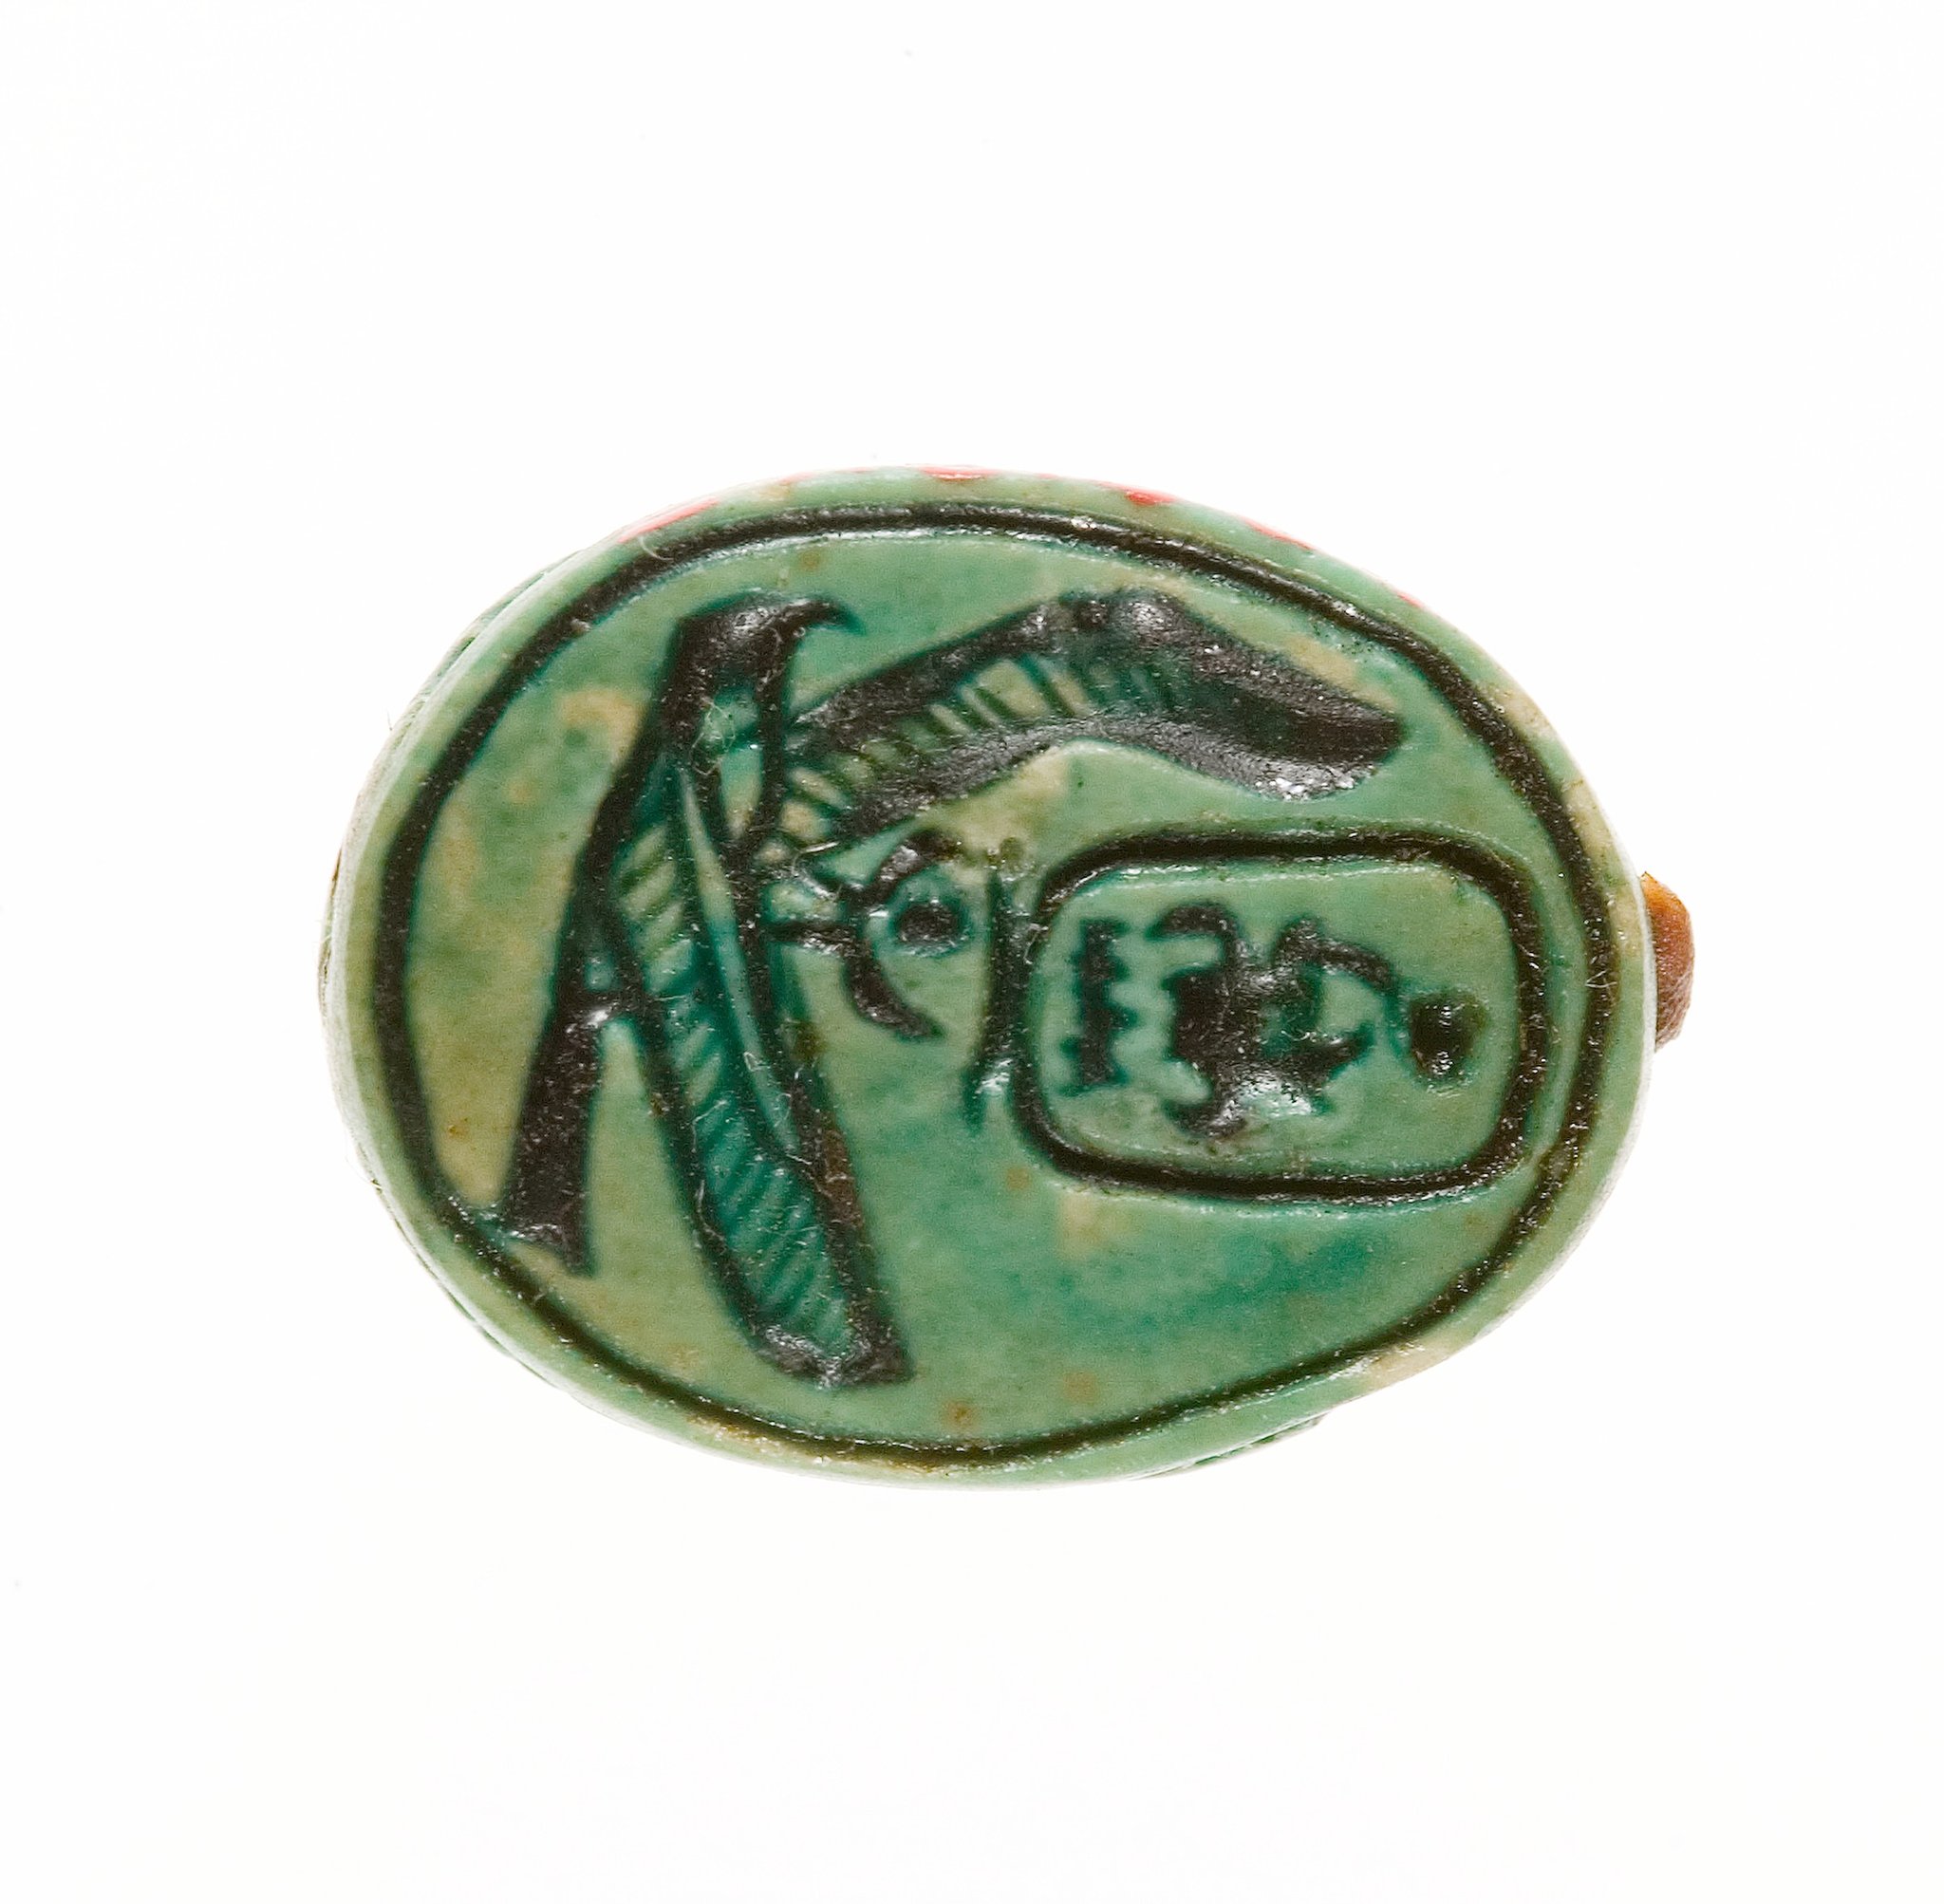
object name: scarab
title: Scarab Inscribed with the Throne Name of Thutmose III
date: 1479-1458 BCE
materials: stone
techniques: glazing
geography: egypt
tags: birds,cartouches,hieroglyphs,scarabs